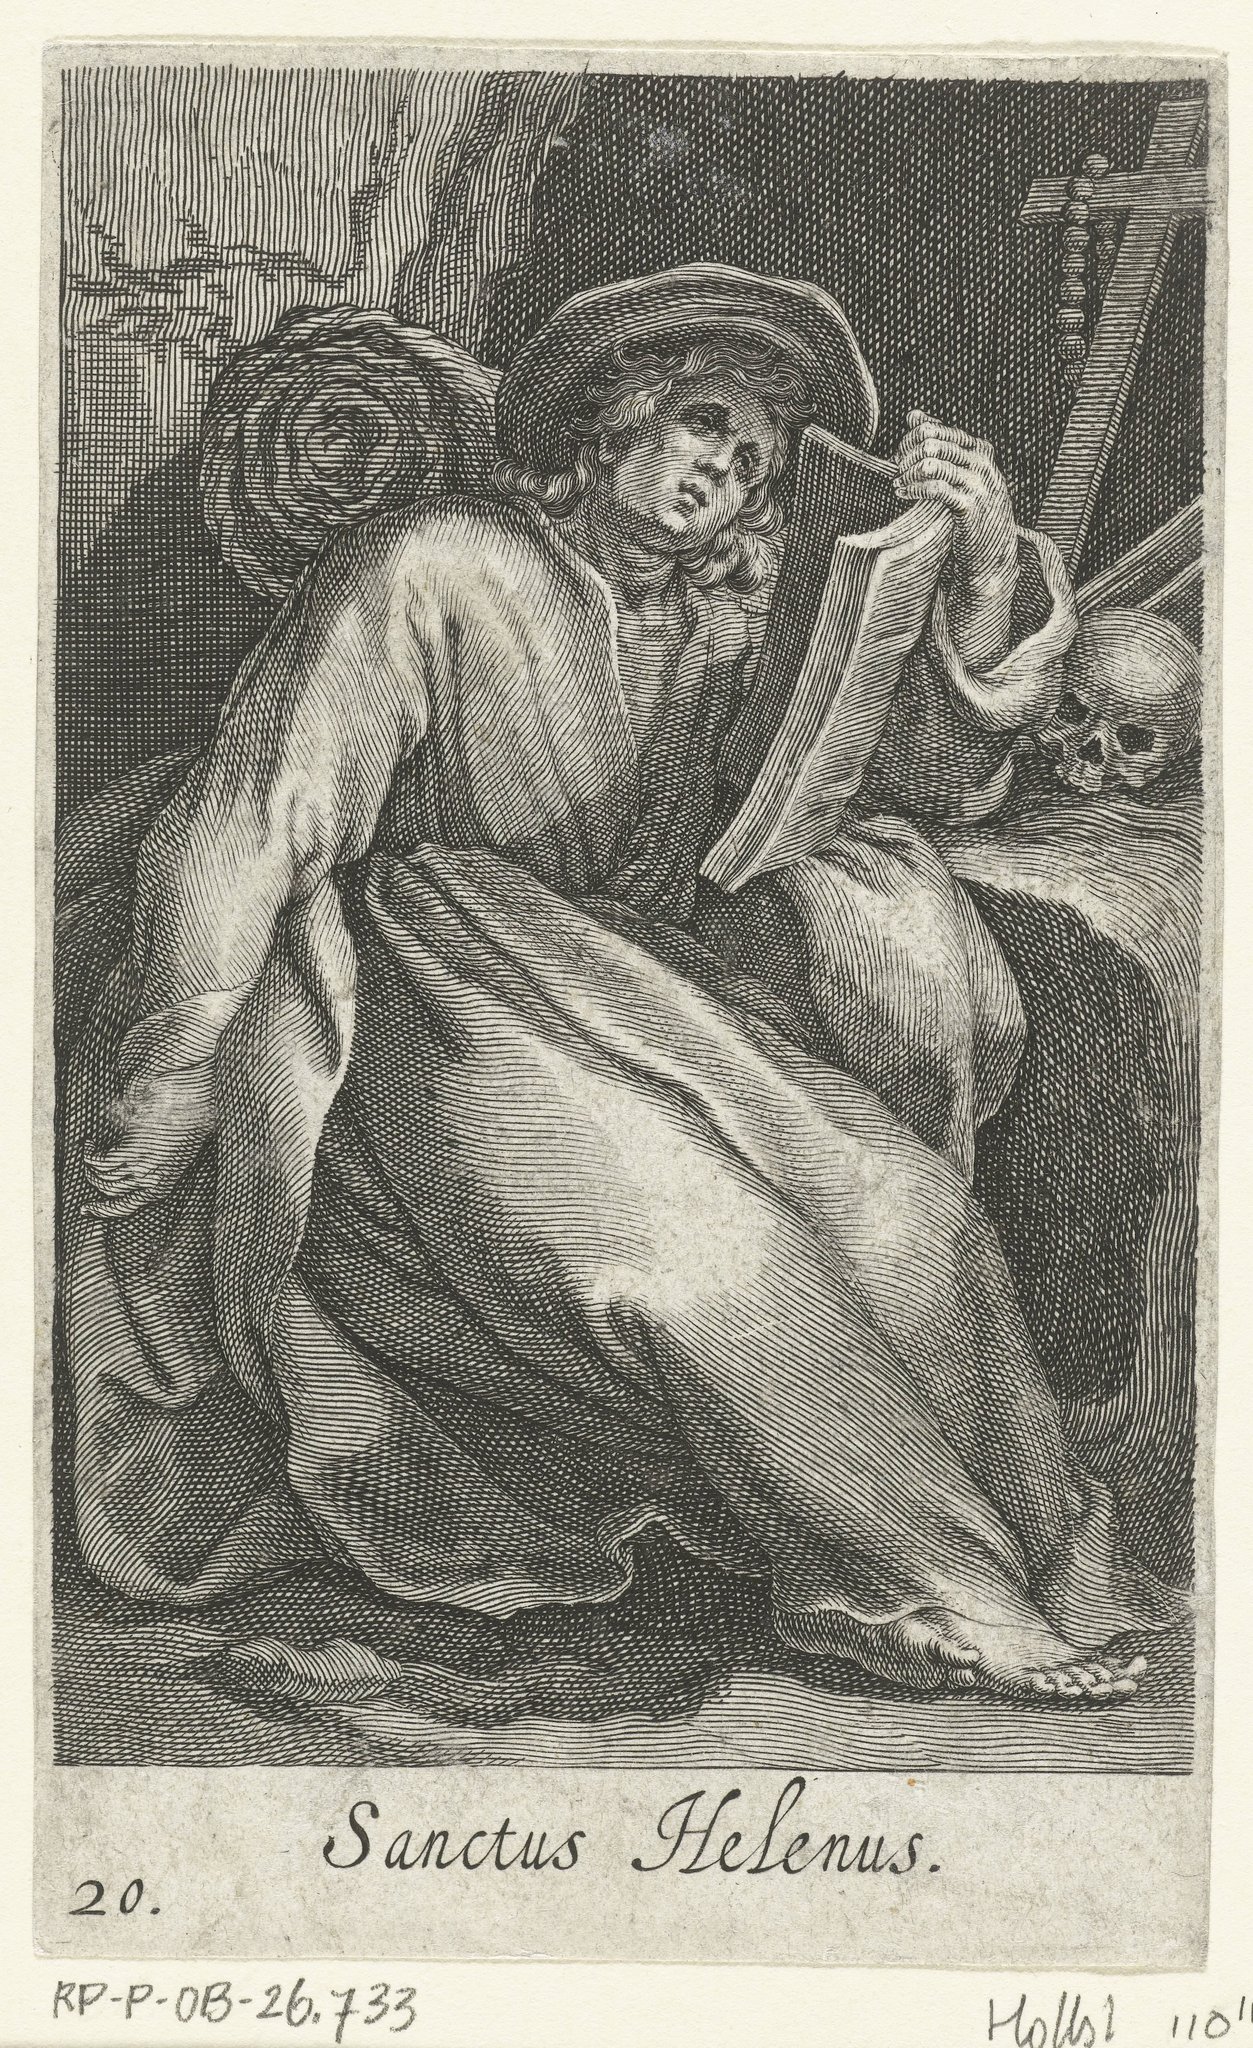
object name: book illustration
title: Kluizenaars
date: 1590-1612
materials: paper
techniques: engraving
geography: antwerp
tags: saints, anchorite, hermit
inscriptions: collector's mark: Lugt 2228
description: Prent uit: Sacra eremus ascetarum, Antwerpen, Hendrick Aertssen, 1619. Eerste gebonden uitgave met in totaal vijftig prenten. Prent uit serie van vijfentwintig mannelijke kluizenaars. In 1612 verscheen een ongebonden editie maar op basis van de gewijzigde opschriften en samenstelling wordt aangenomen dat de prenten van de uitgave 1619 ook in 1612 of iets daarvoor gedrukt werden. Roethlisberger beschouwt de uitgave van 1619 als de eerste staat en de ongebonden editie van 1612 als de tweede staat (Roethlisberger 1993, p. 171, 172).